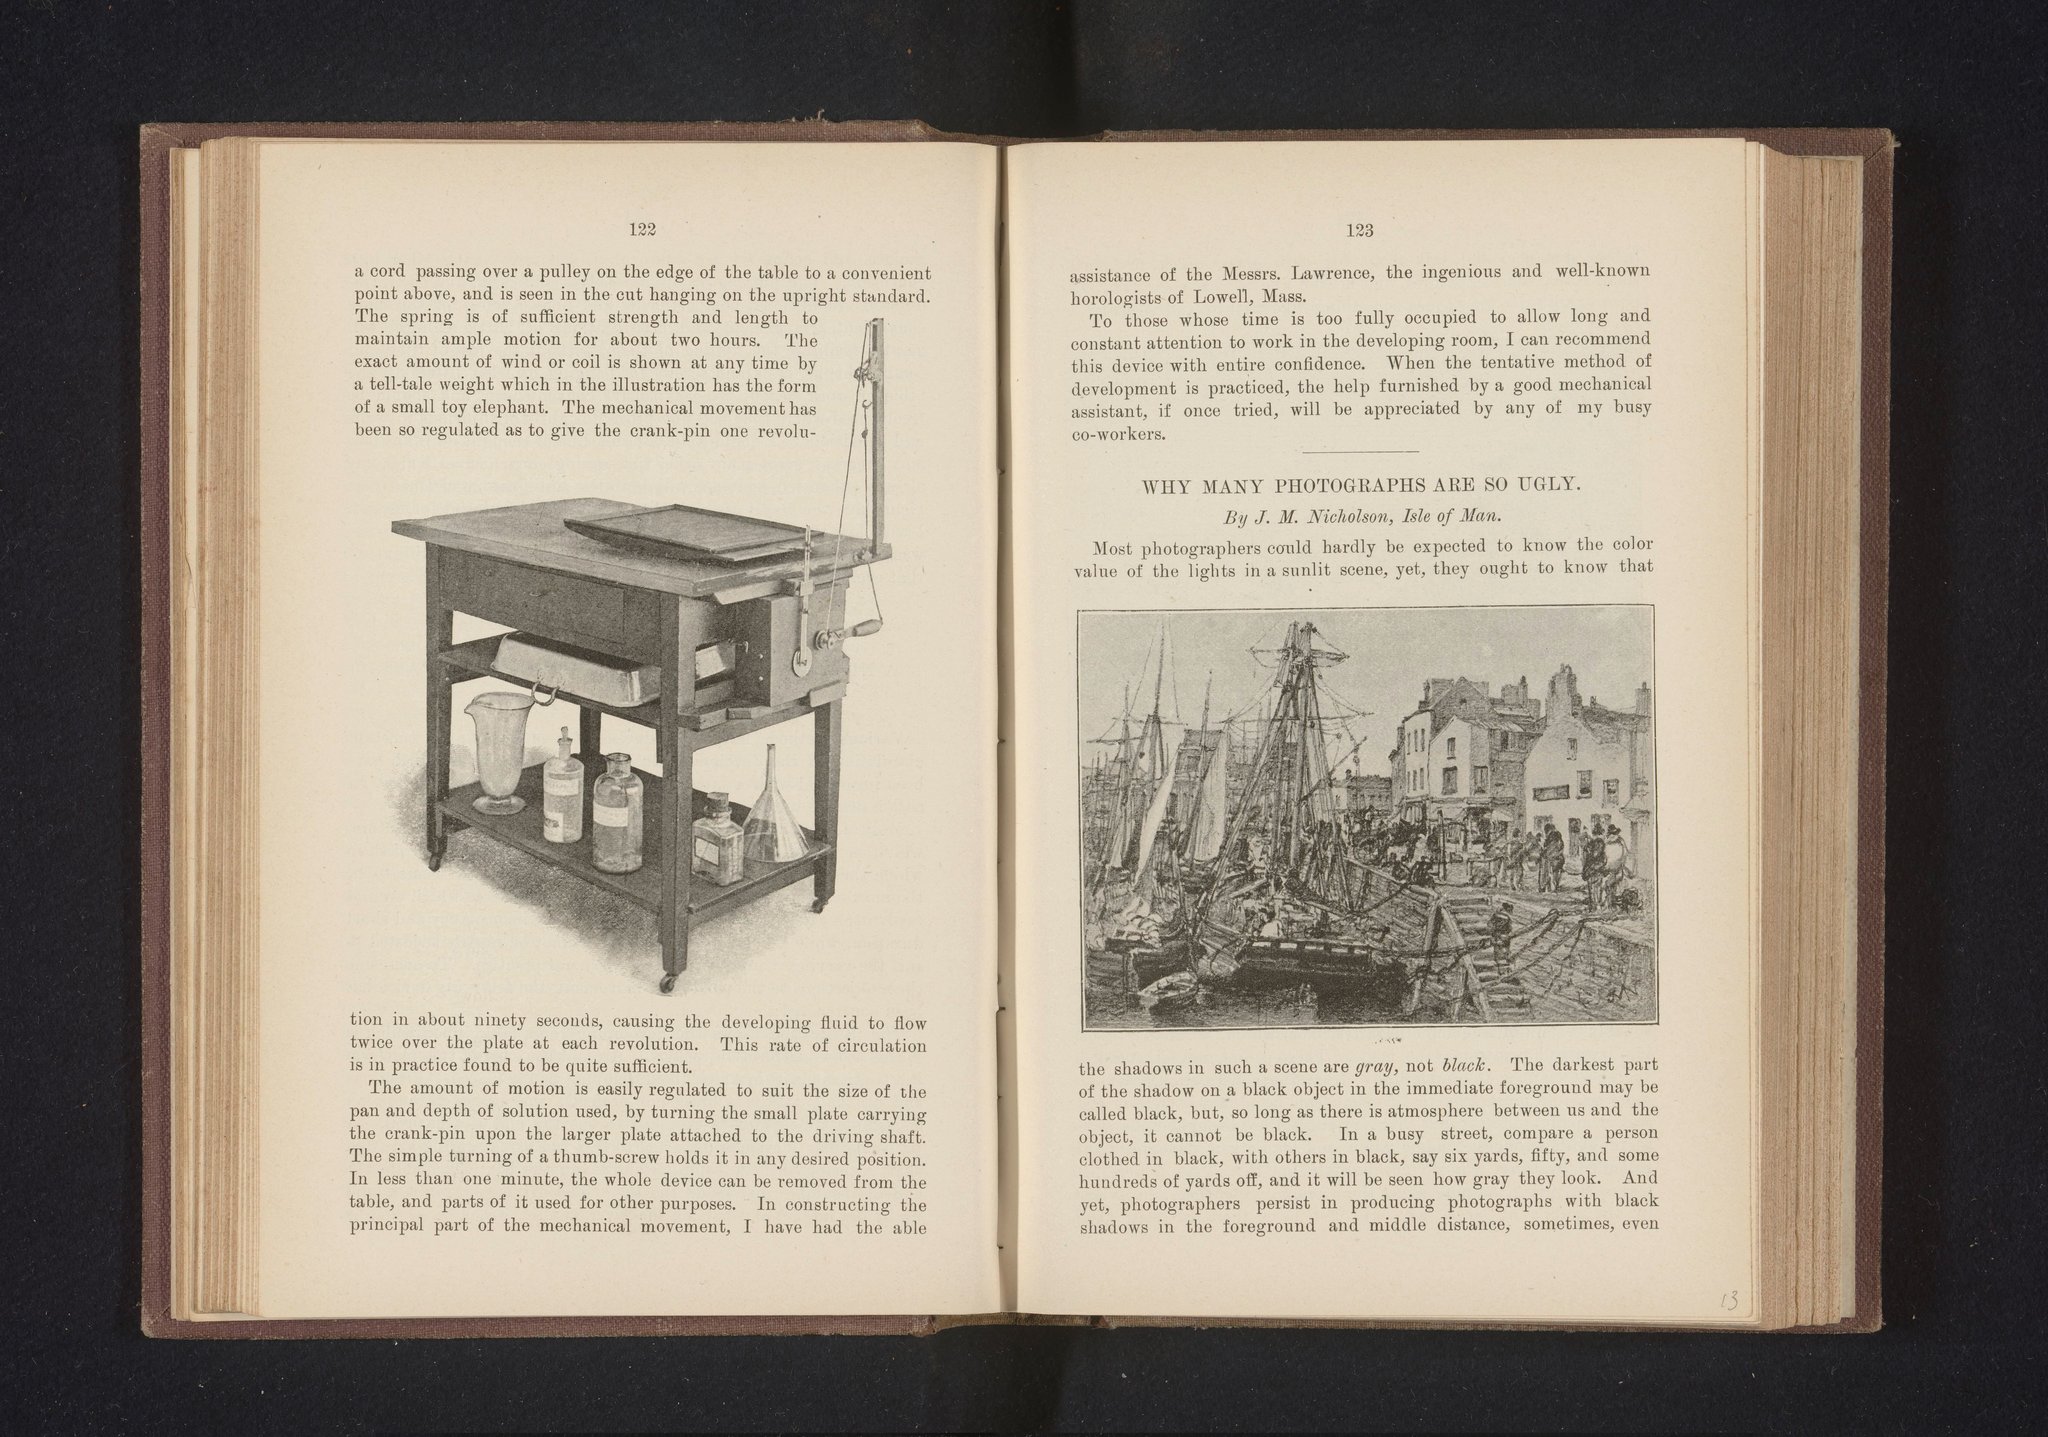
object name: photomechanical print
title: Tafel om ontwikkelvloeistof te circuleren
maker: Anonymous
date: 1888-1893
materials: paper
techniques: autotype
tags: table